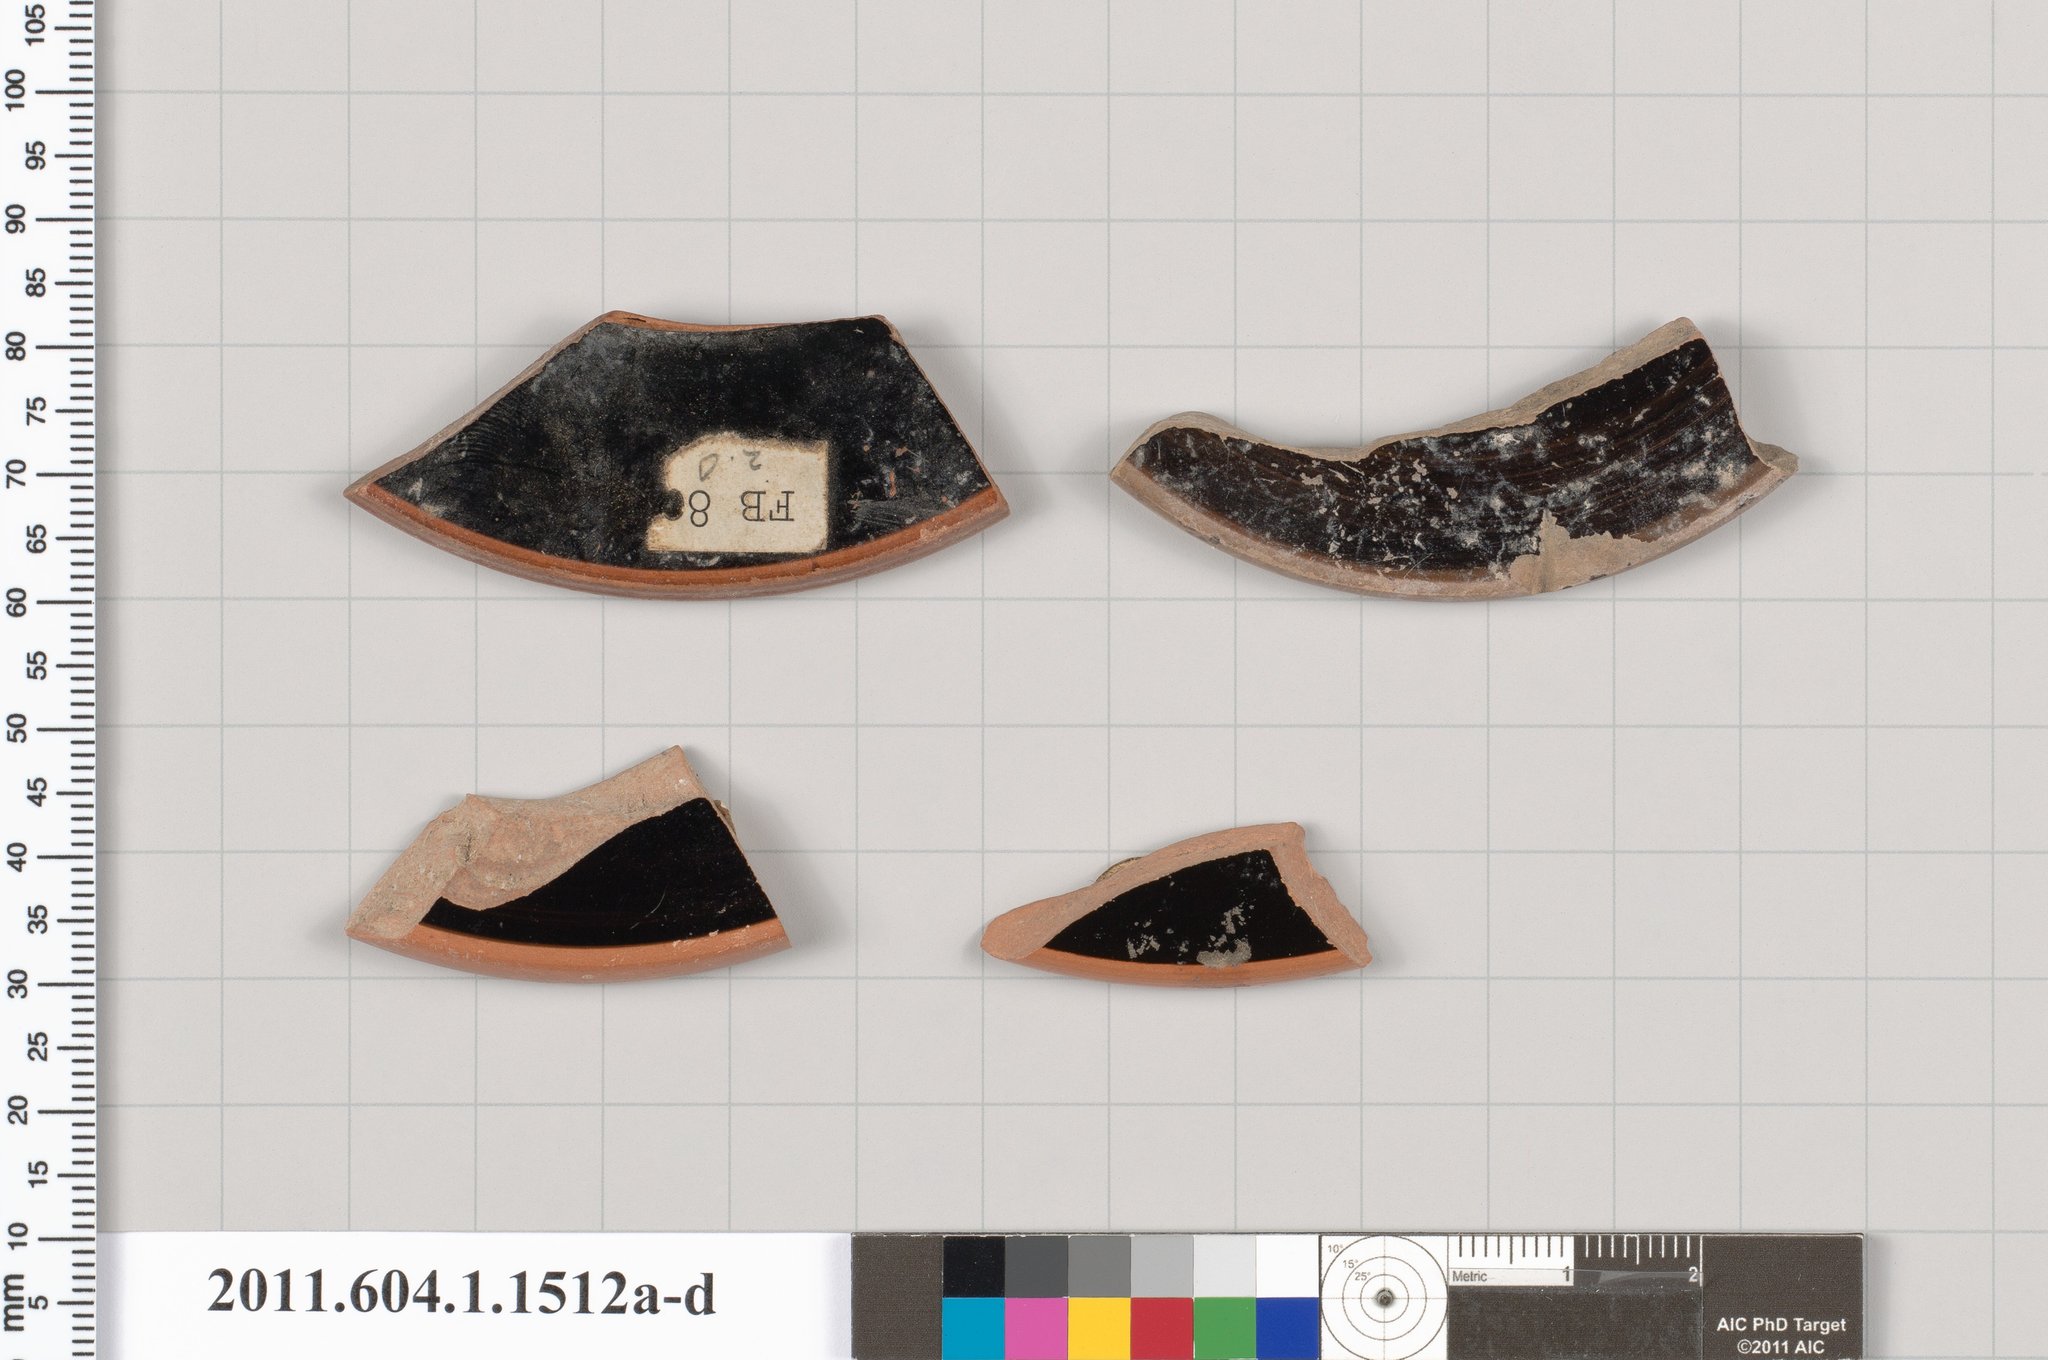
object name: kylix fragment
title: Terracotta fragments of kylikes (drinking cups)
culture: greek, attic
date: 500-401 BCE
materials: terracotta